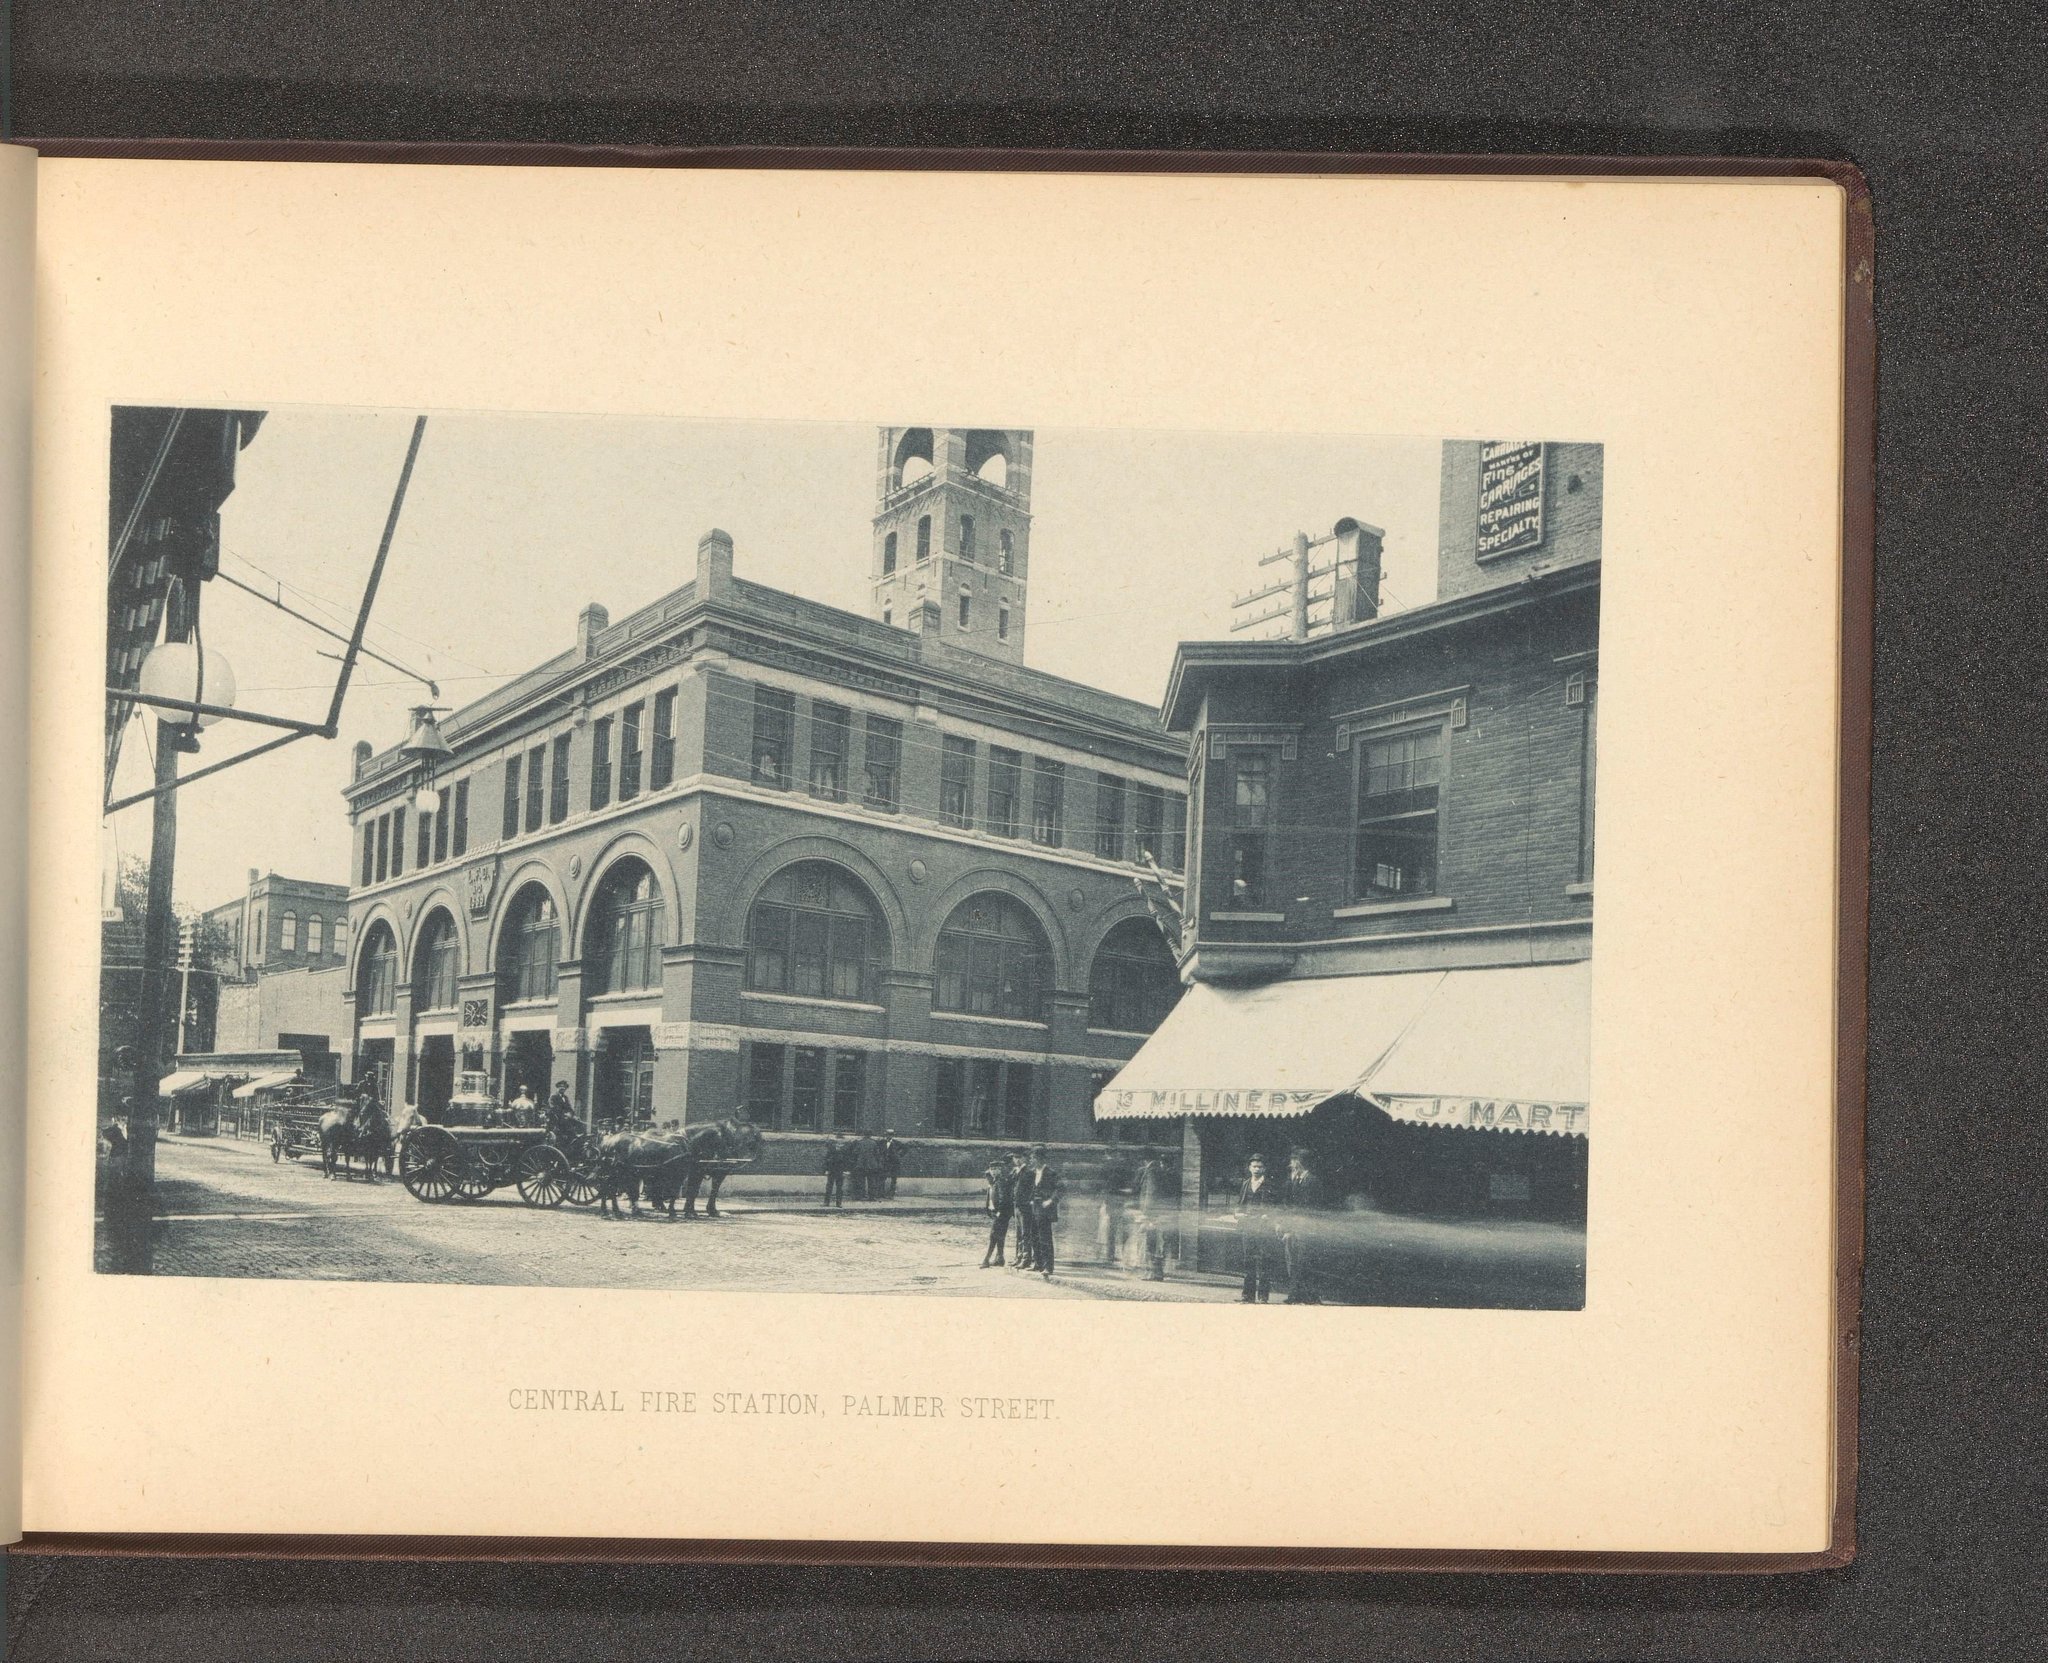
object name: page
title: Central fire station, Palmer street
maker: Anonymous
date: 1887-1892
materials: paper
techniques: photograph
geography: lowell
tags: fire-department, fire-brigade, four-wheeled vehicle drawn by two animals, street